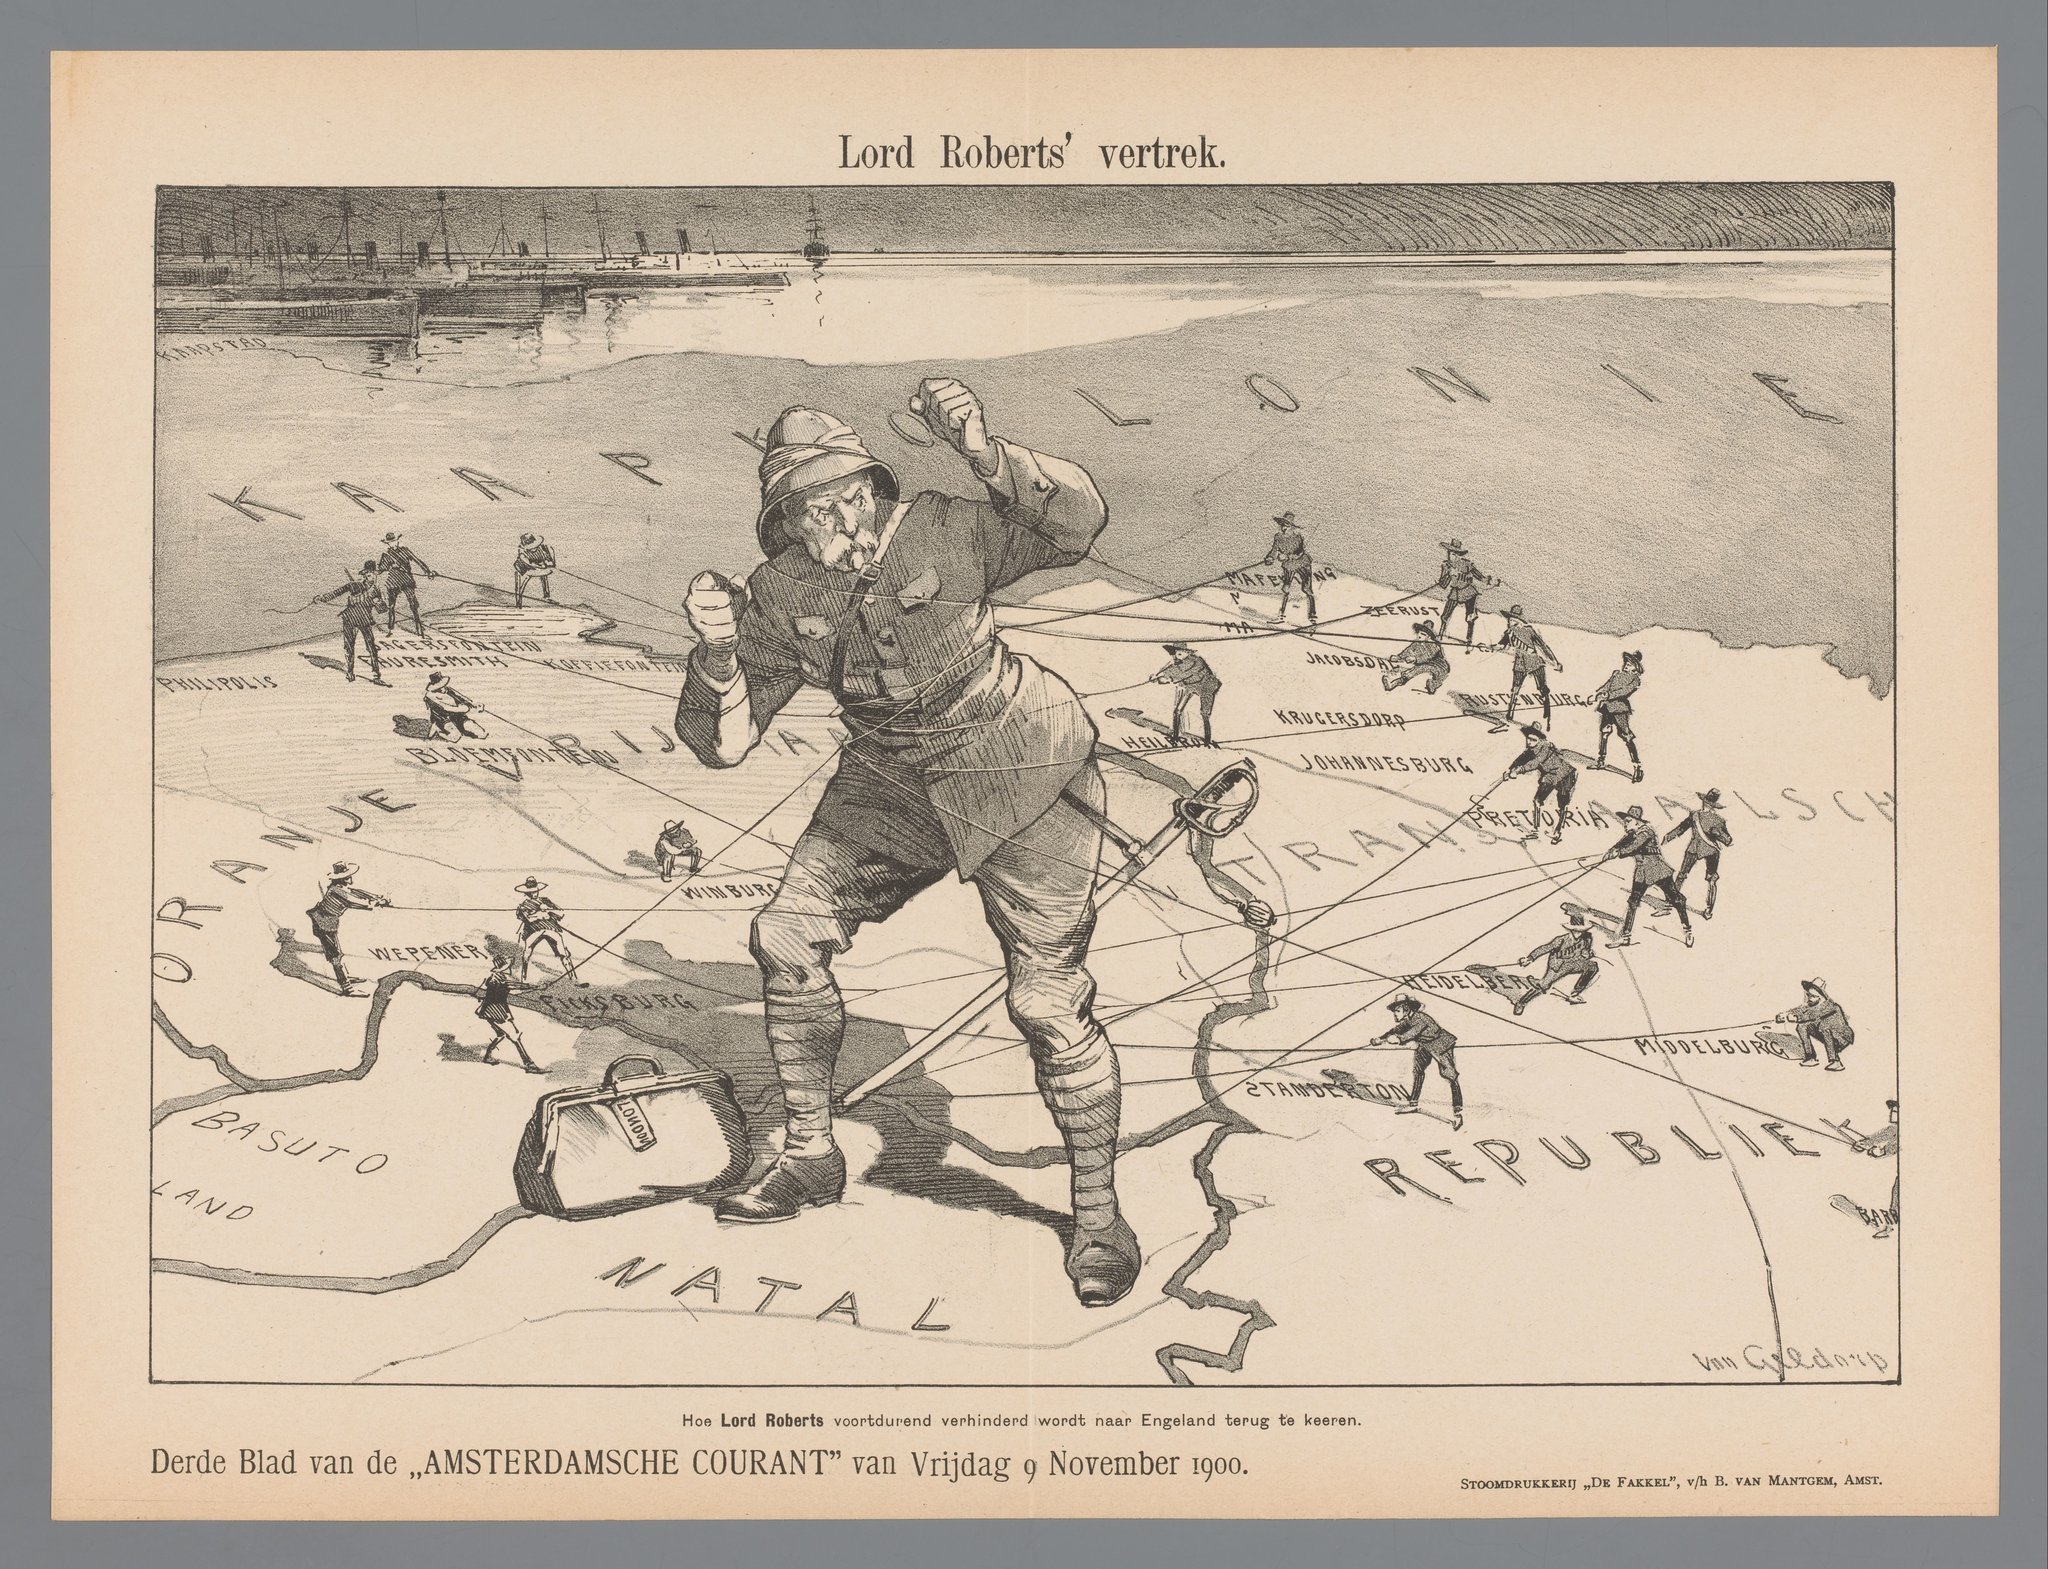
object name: cartoon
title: Lord Roberts' vertrek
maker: petrus van geldorp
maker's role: draughtsman, print maker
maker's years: 1872-1939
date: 1900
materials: paper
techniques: lithograph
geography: amsterdam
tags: governmental and representative bodies, historical persons, political caricatures and satires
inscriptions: date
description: Prent uit het bijvoegsel van: De Amsterdamsche Courant, 9 november 1900.